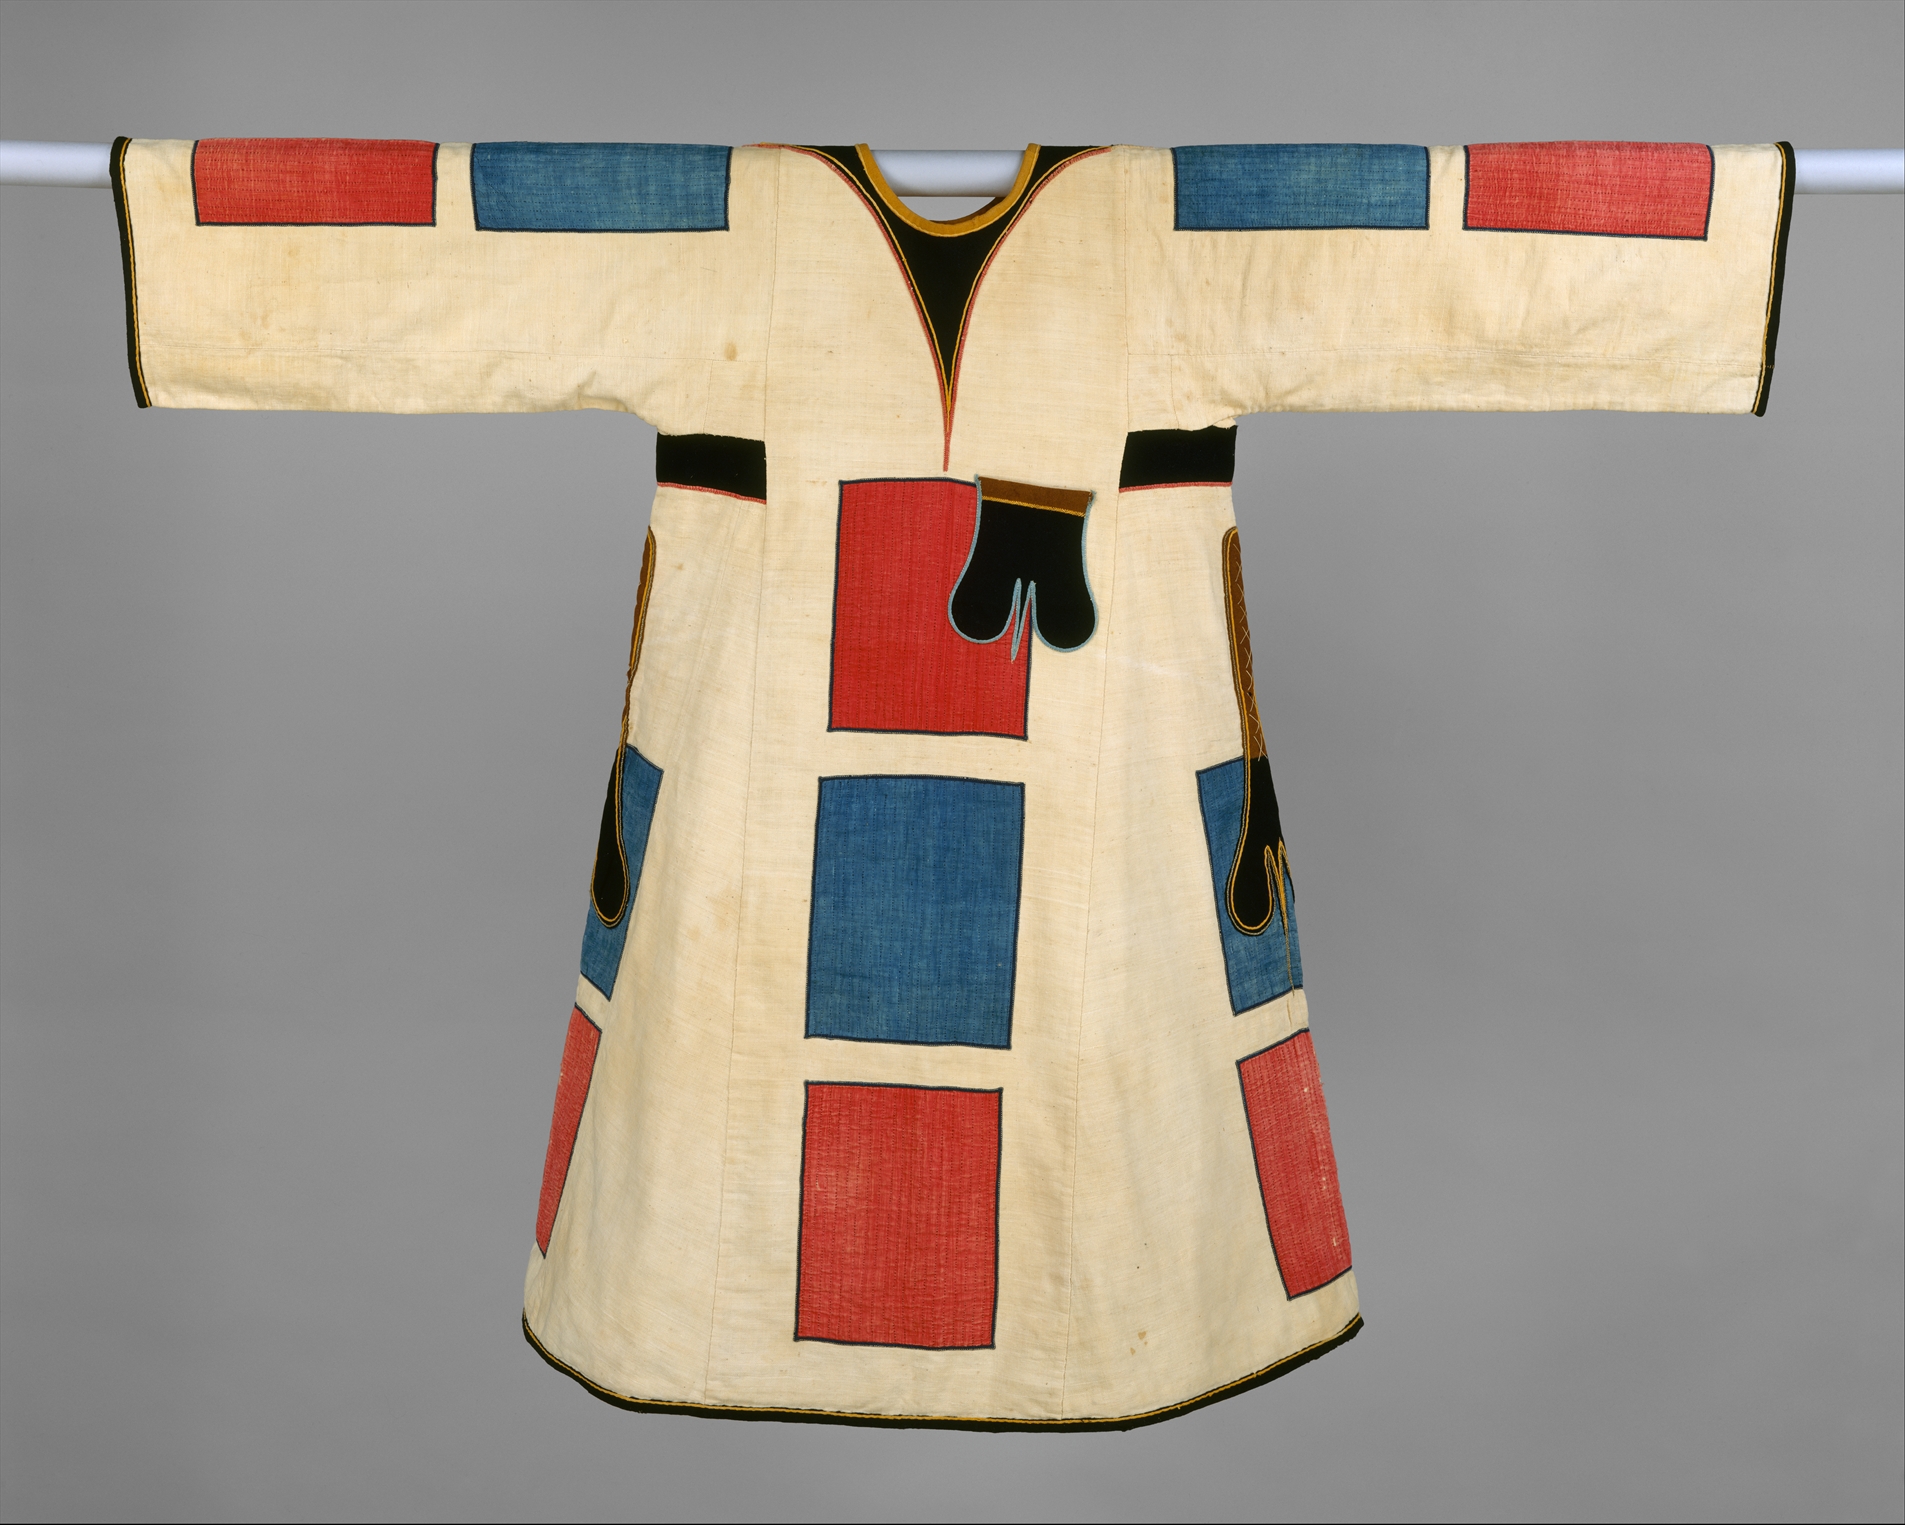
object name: tunic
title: Jibba (tunic)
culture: mahdist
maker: mahdist artist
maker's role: artist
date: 1881-1898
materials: cotton, dye, wool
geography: sudan